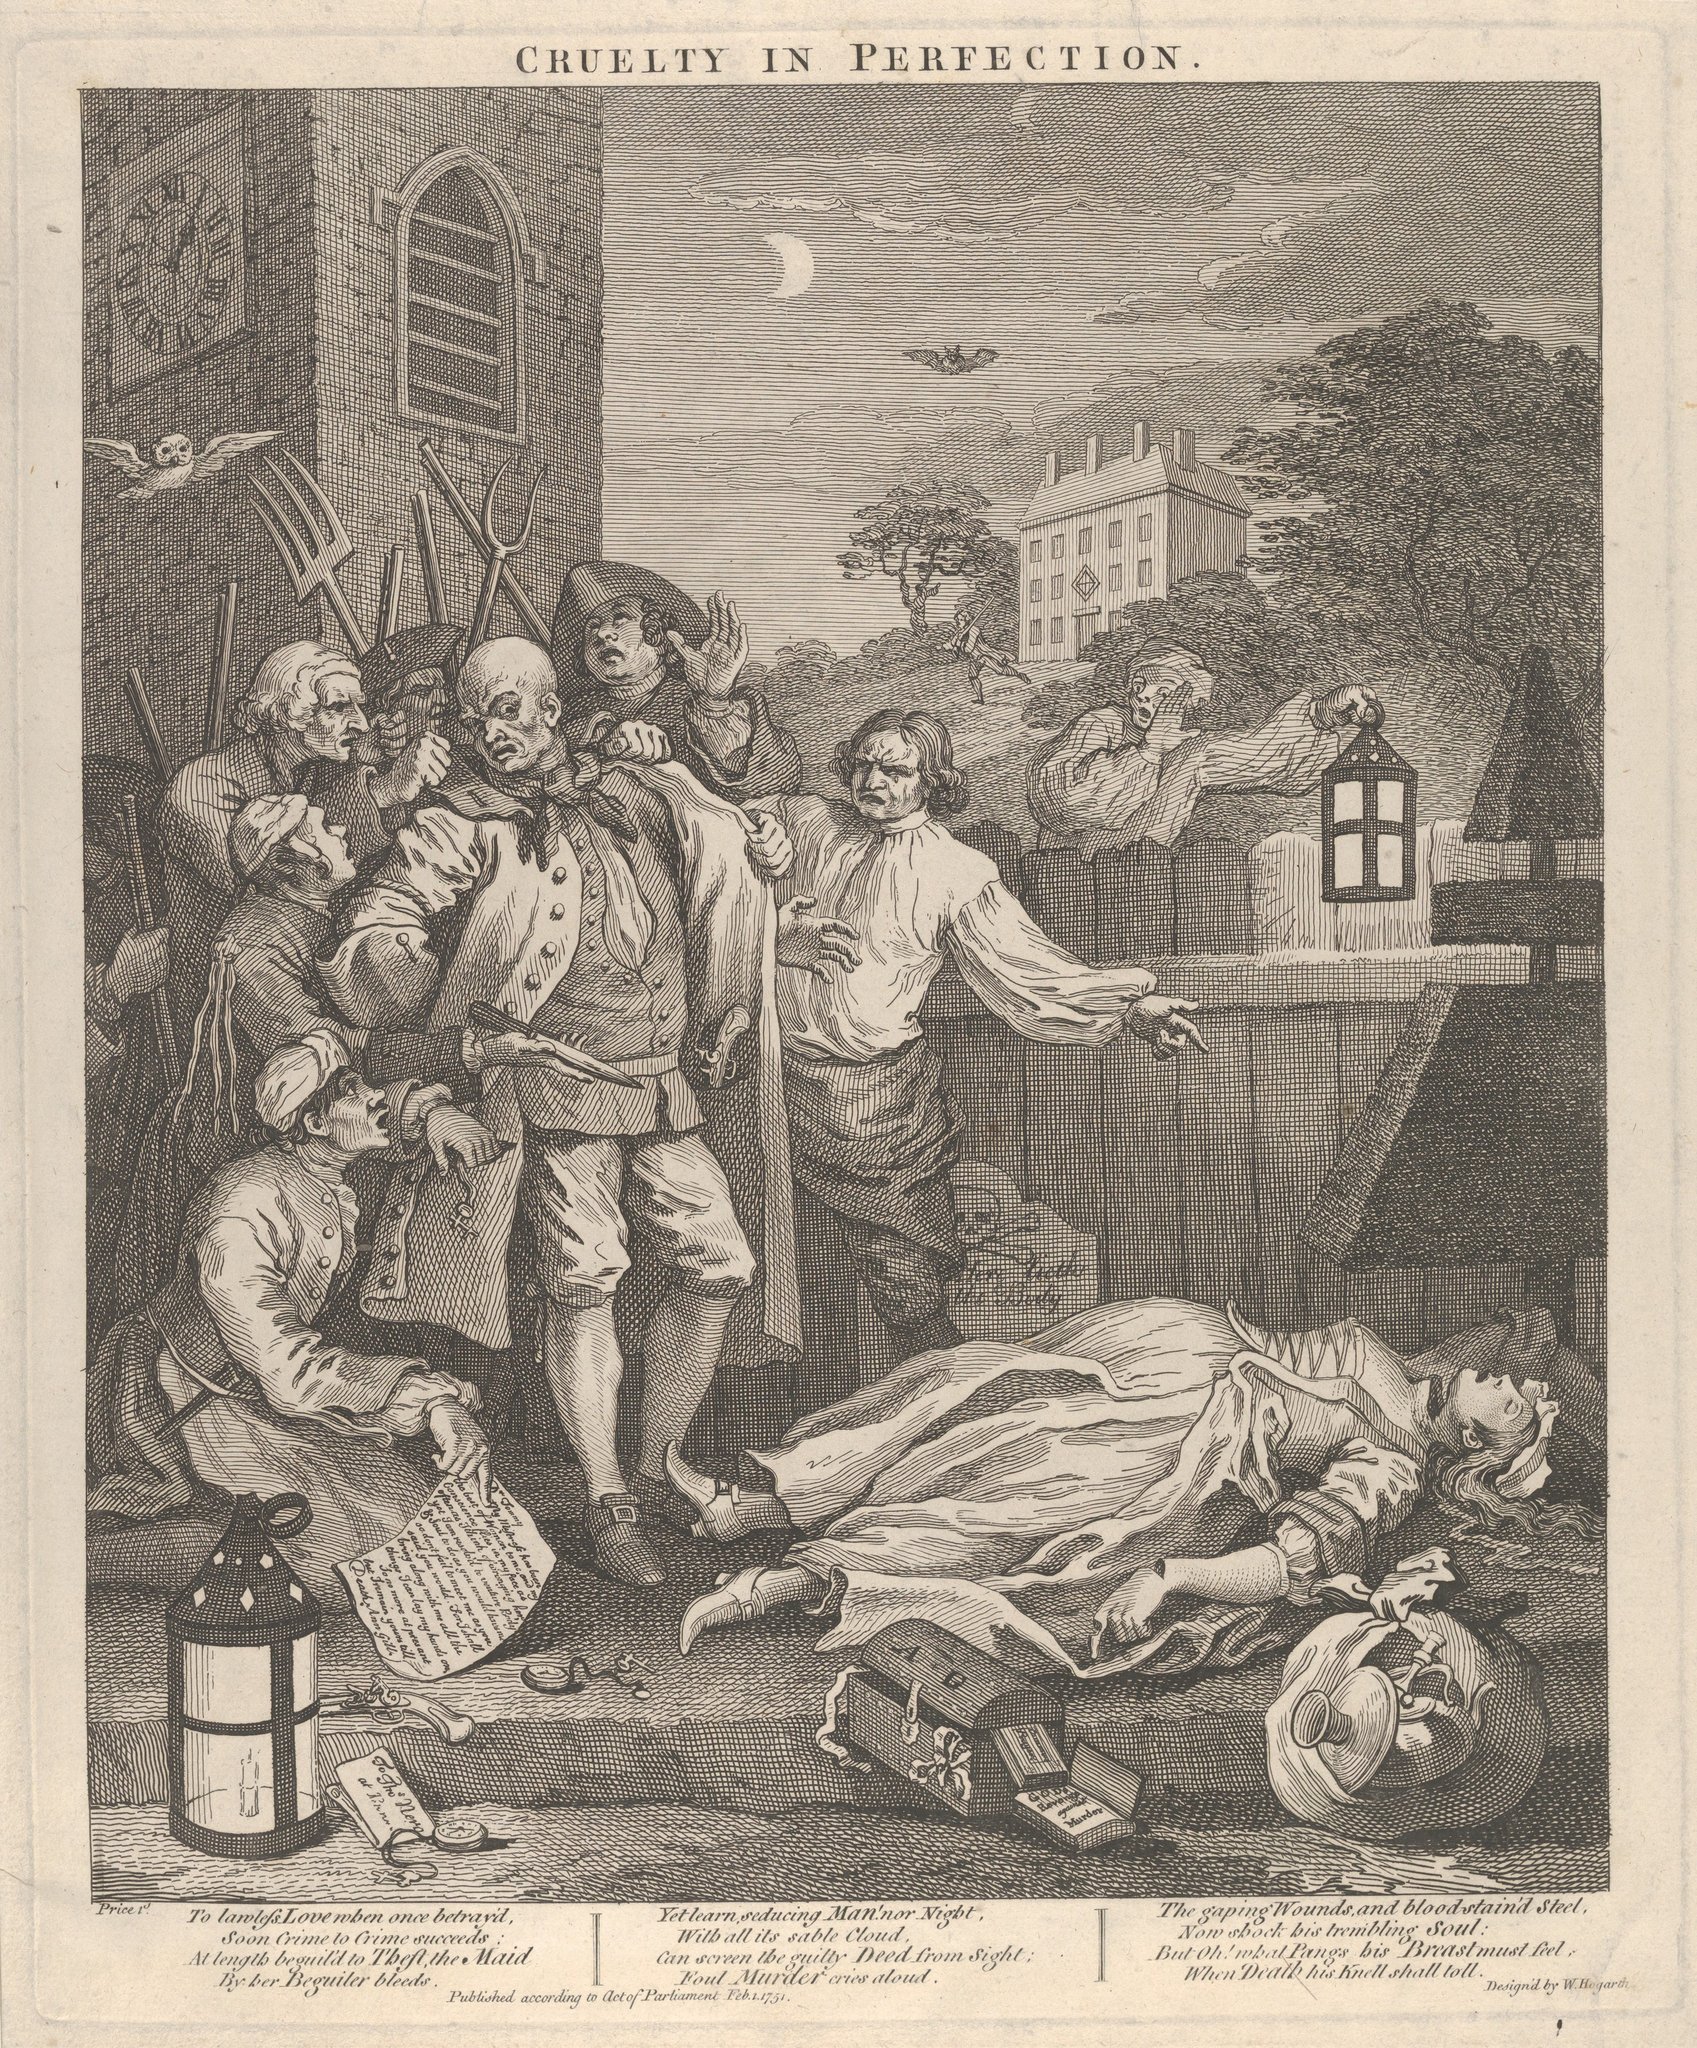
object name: print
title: Cruelty in Perfection (The Four Stages of Cruelty)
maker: william hogarth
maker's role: artist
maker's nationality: british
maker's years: 1697-1764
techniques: engraving, etching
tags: men,women,death